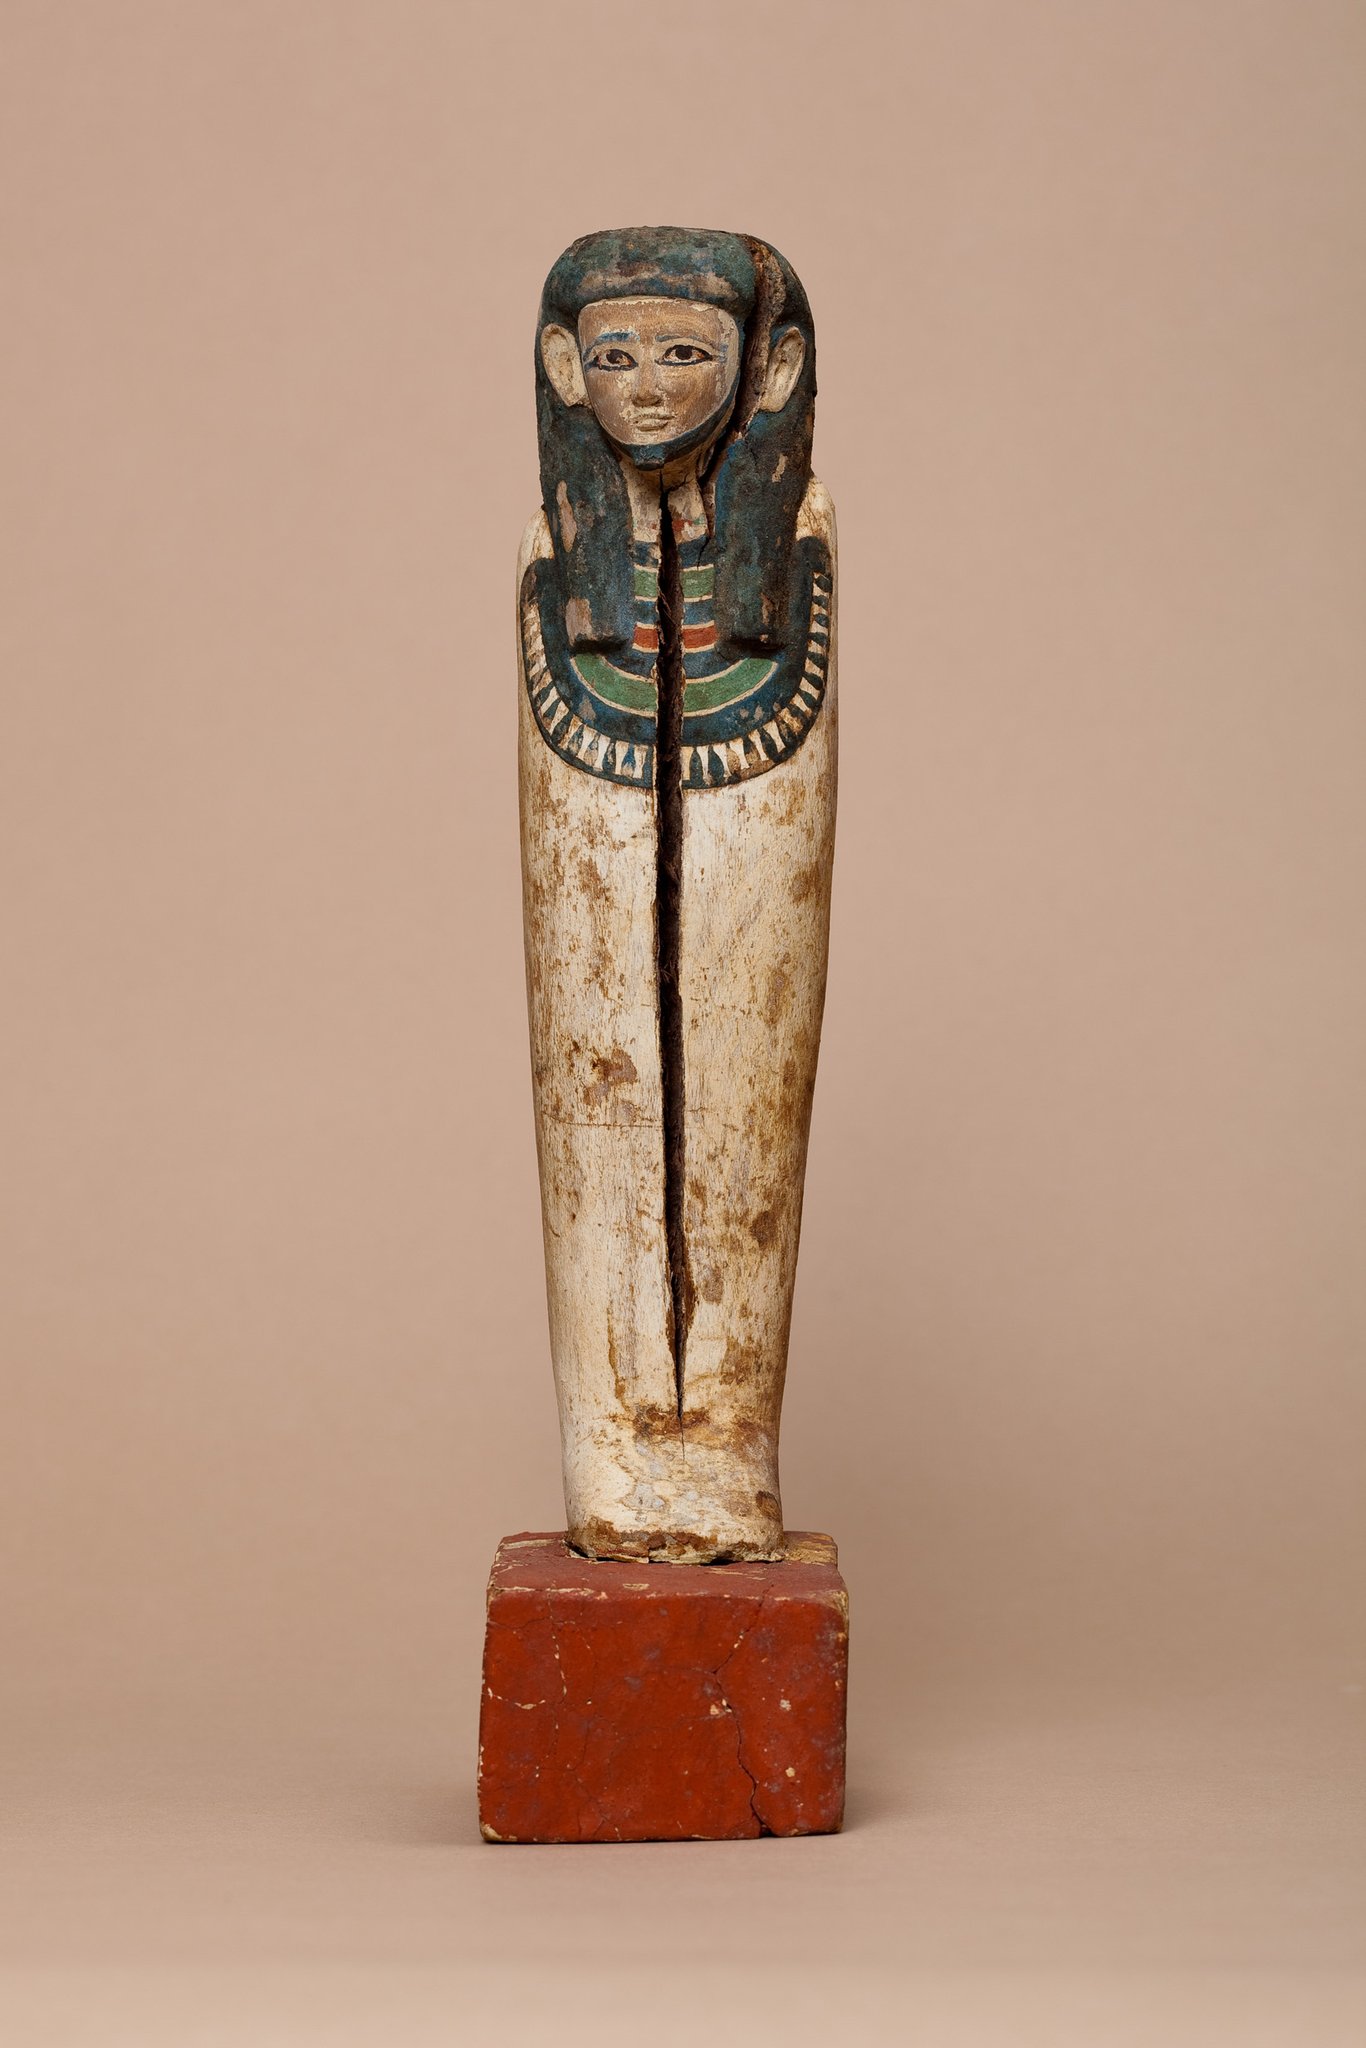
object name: shabti, mummiform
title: Shabti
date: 1981-1802 BCE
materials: paint, wood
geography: egypt